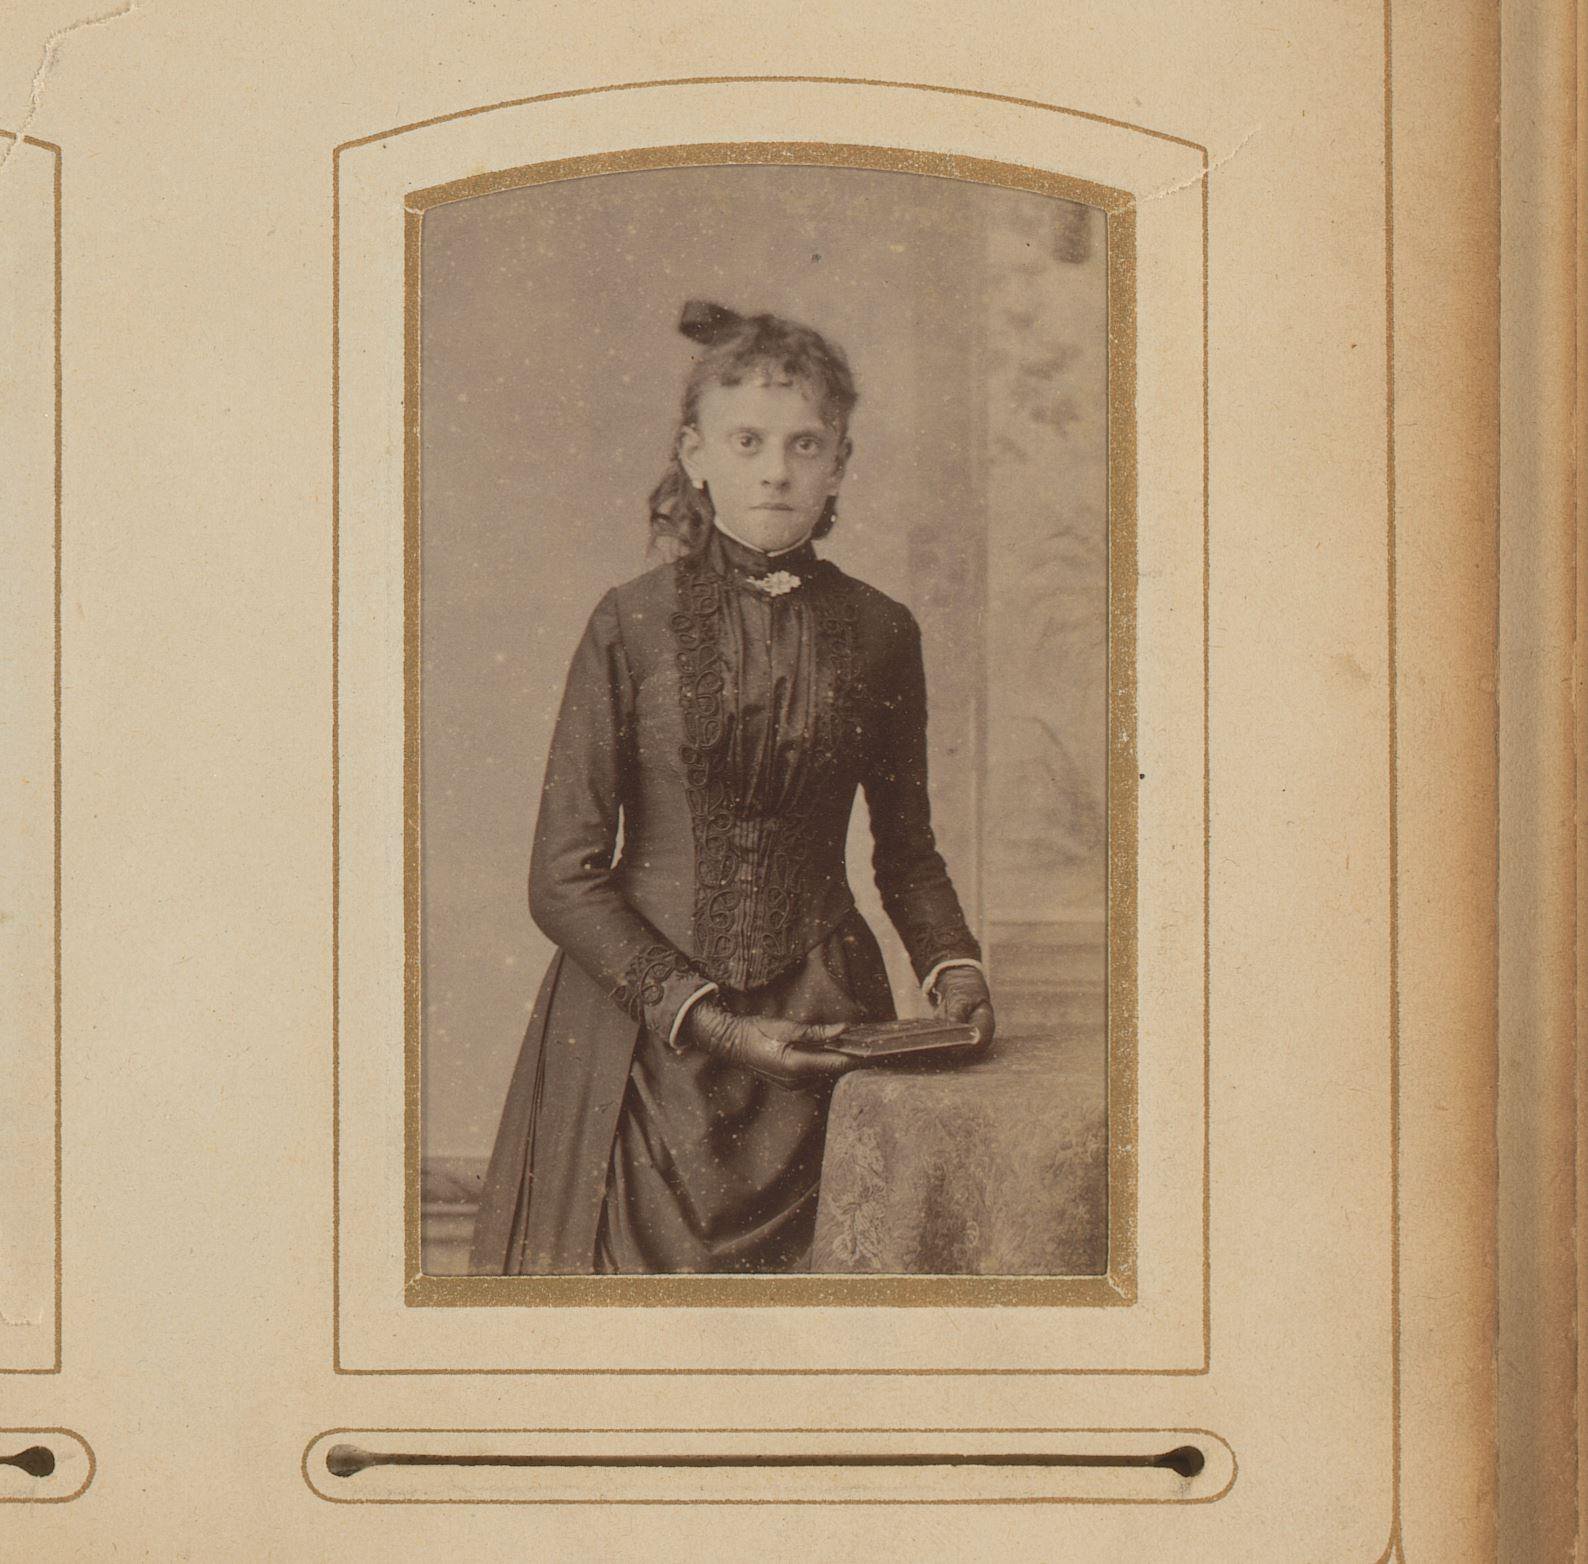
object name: album leaf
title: Portret van een jonge vrouw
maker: Anonymous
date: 1860-1900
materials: cardboard, photographic support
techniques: albumen print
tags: adolescent, young woman, maiden, historical persons - bb - woman